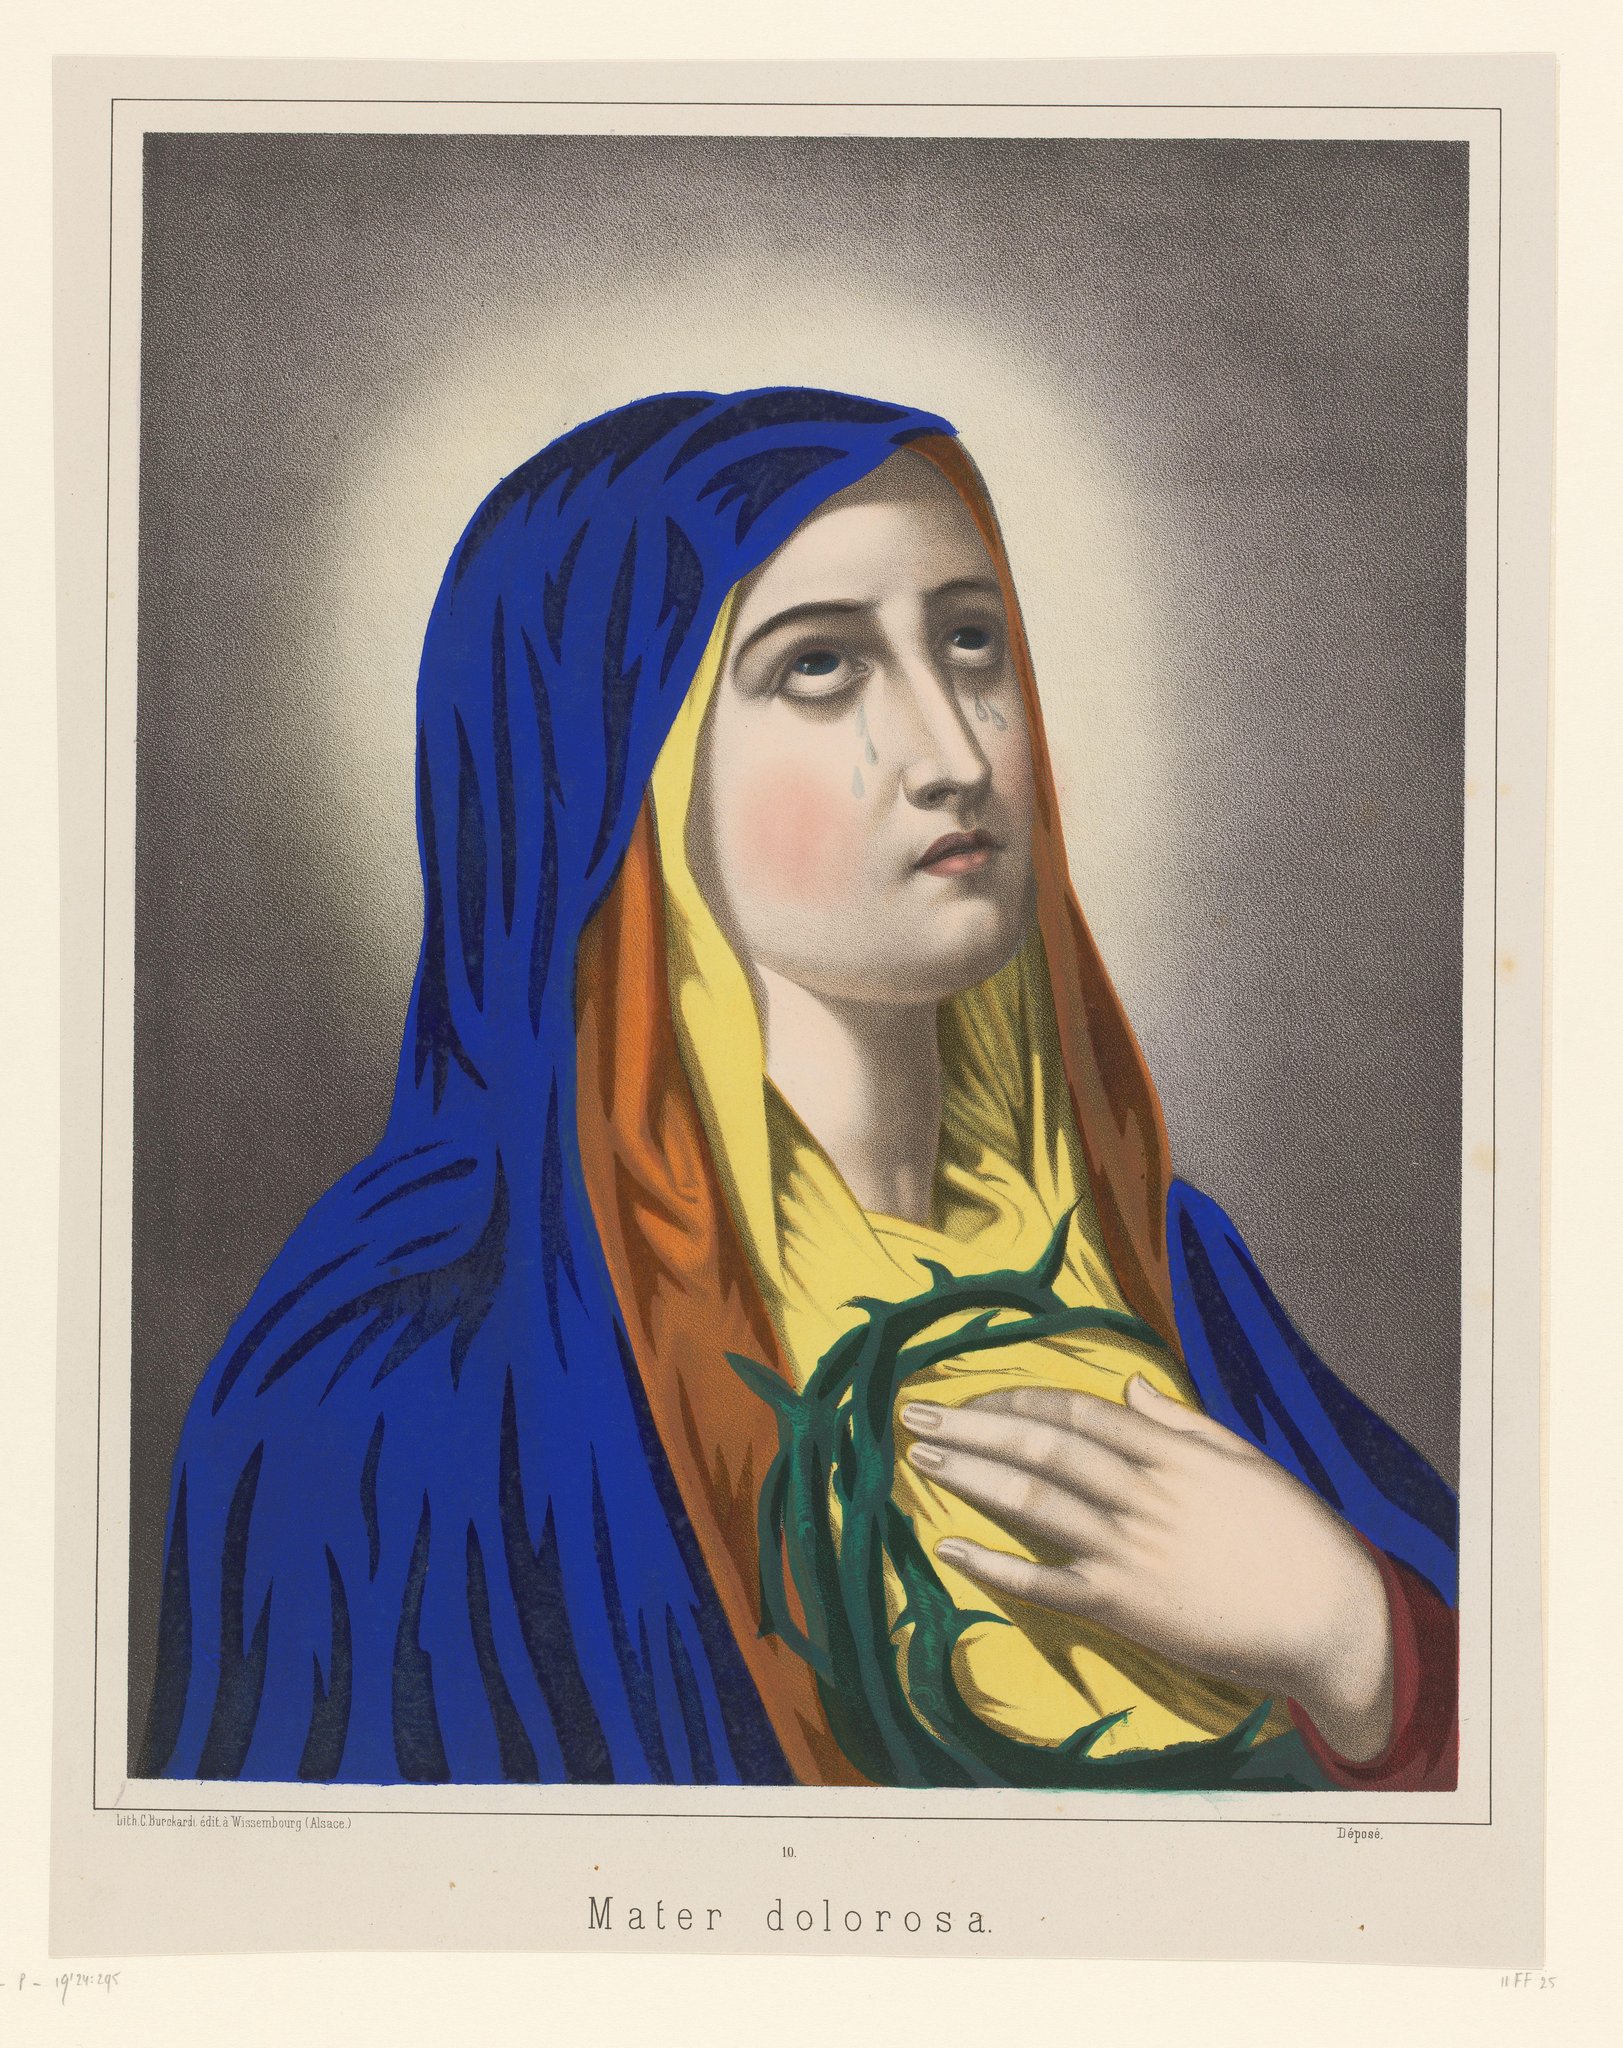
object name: print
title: Maria als Mater Dolorosa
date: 1870-1889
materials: paper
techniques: chromolithography, hand coloring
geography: wissembourg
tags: mary with the instruments of the passion - ff - 'mater dolorosa', head or bust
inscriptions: collector's mark: Lugt 2233